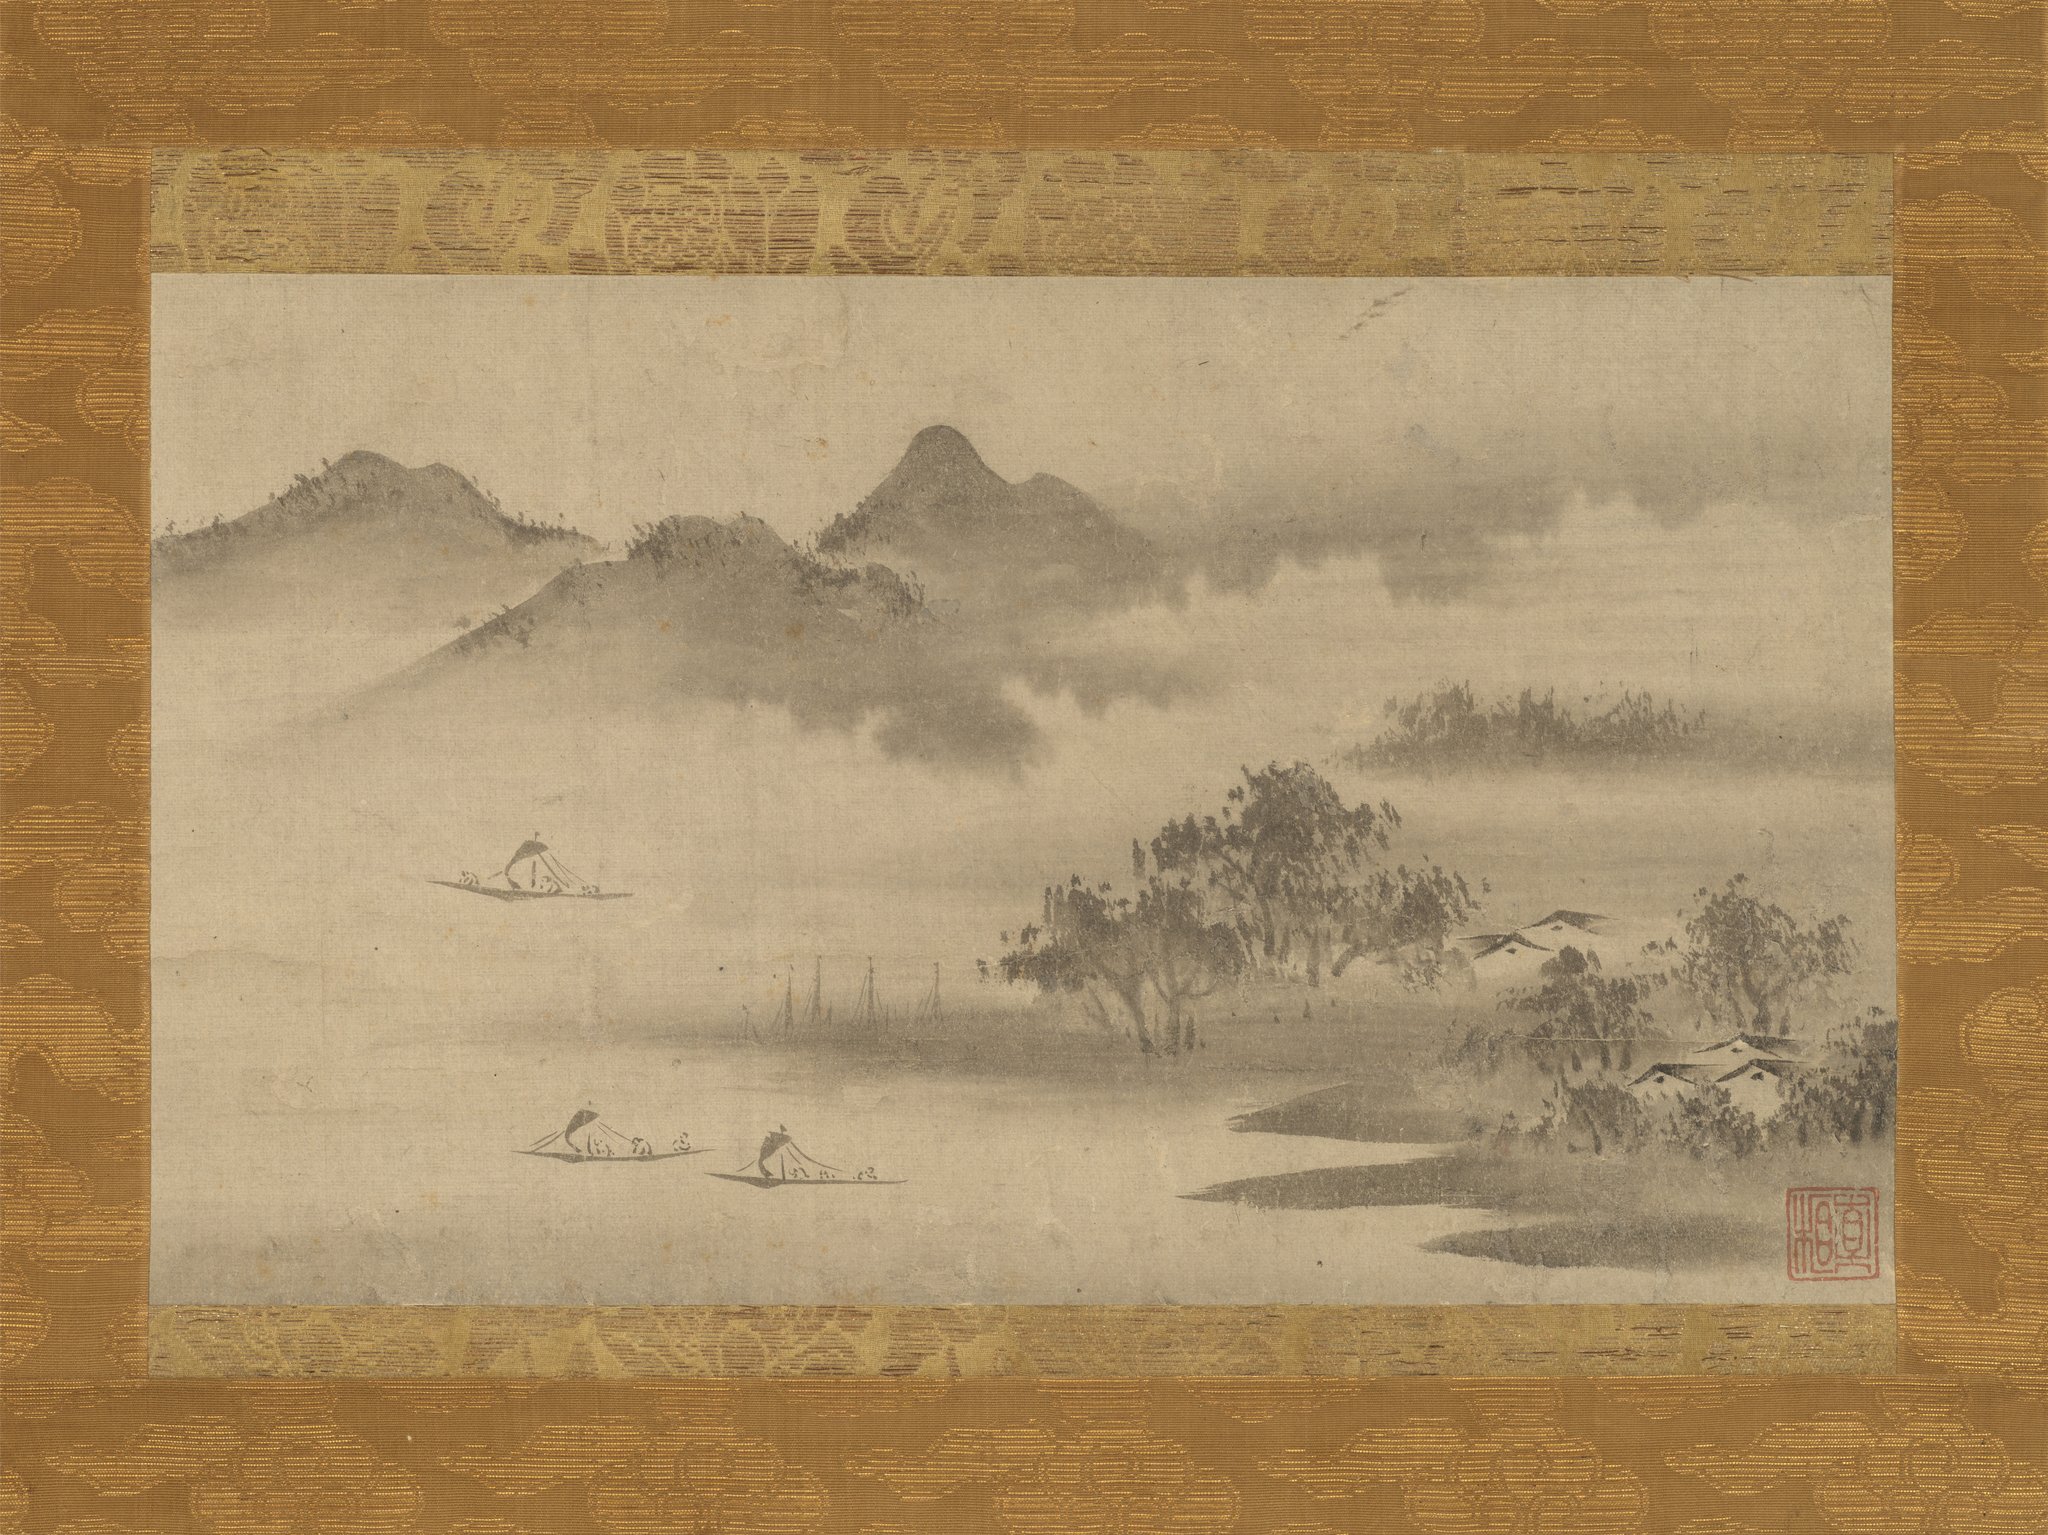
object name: hanging scroll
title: Landscape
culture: japanese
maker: sōami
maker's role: artist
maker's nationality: japanese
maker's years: 1485-1525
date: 1601-1700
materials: ink, paper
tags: hills,landscapes